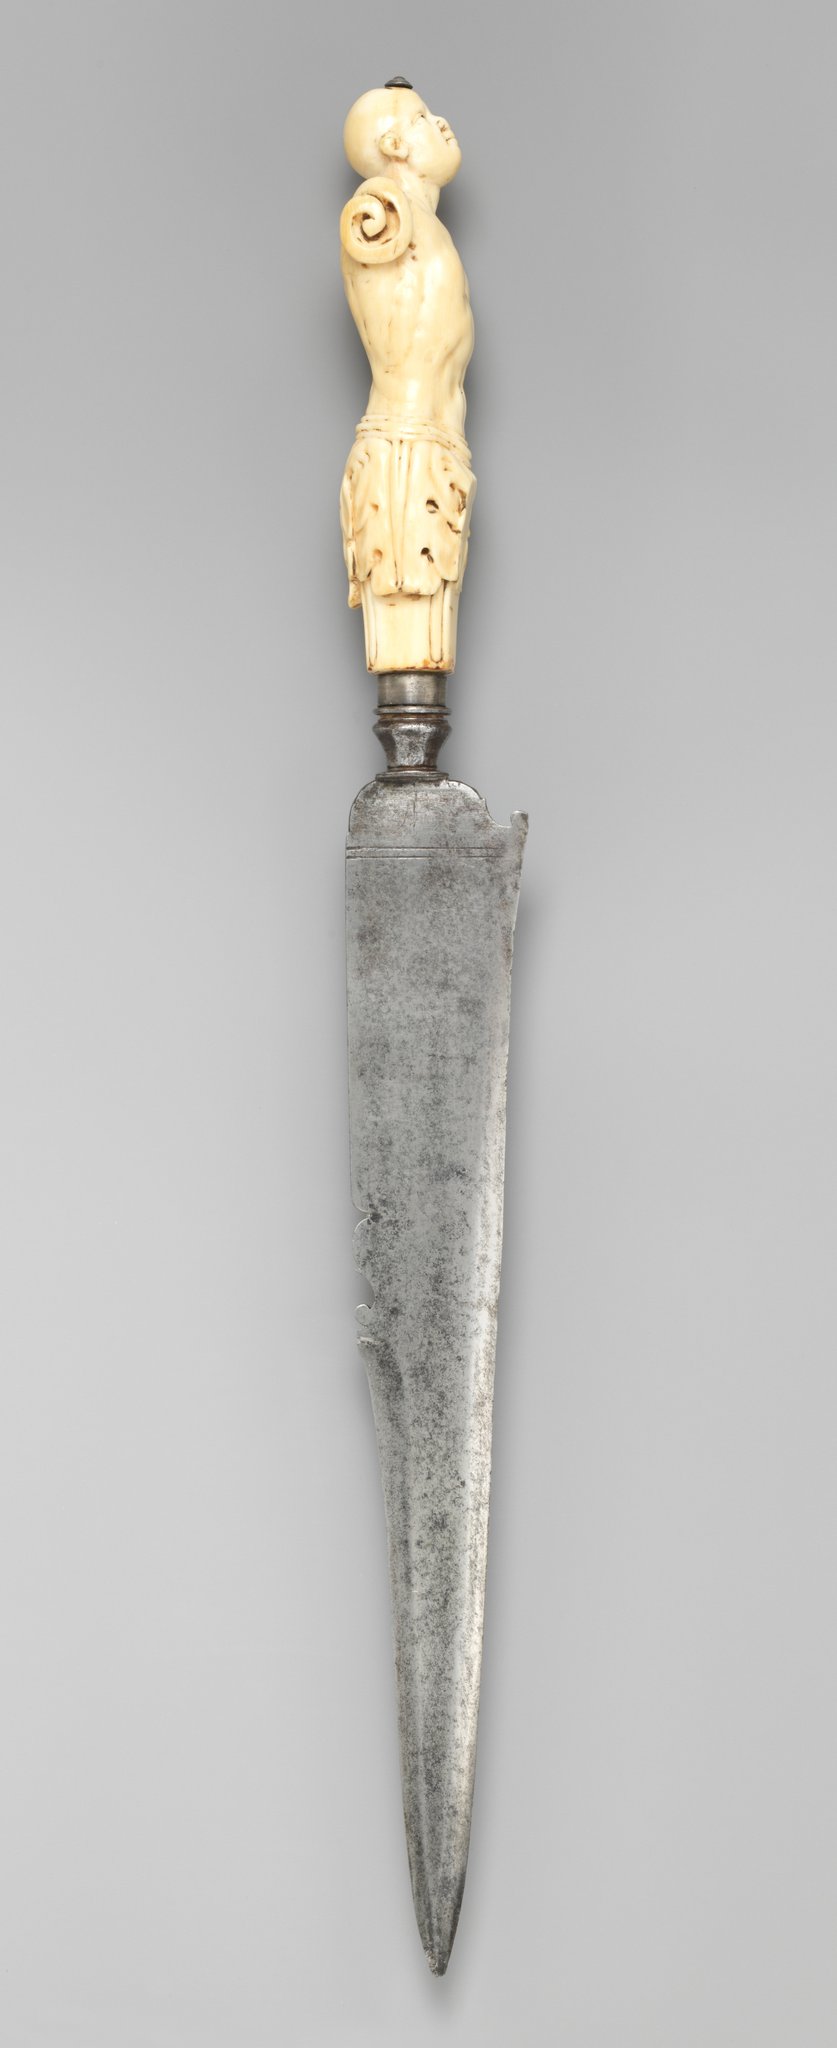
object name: knife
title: Carving knife with handle of nude male torso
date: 1601-1625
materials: ivory, steel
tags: men